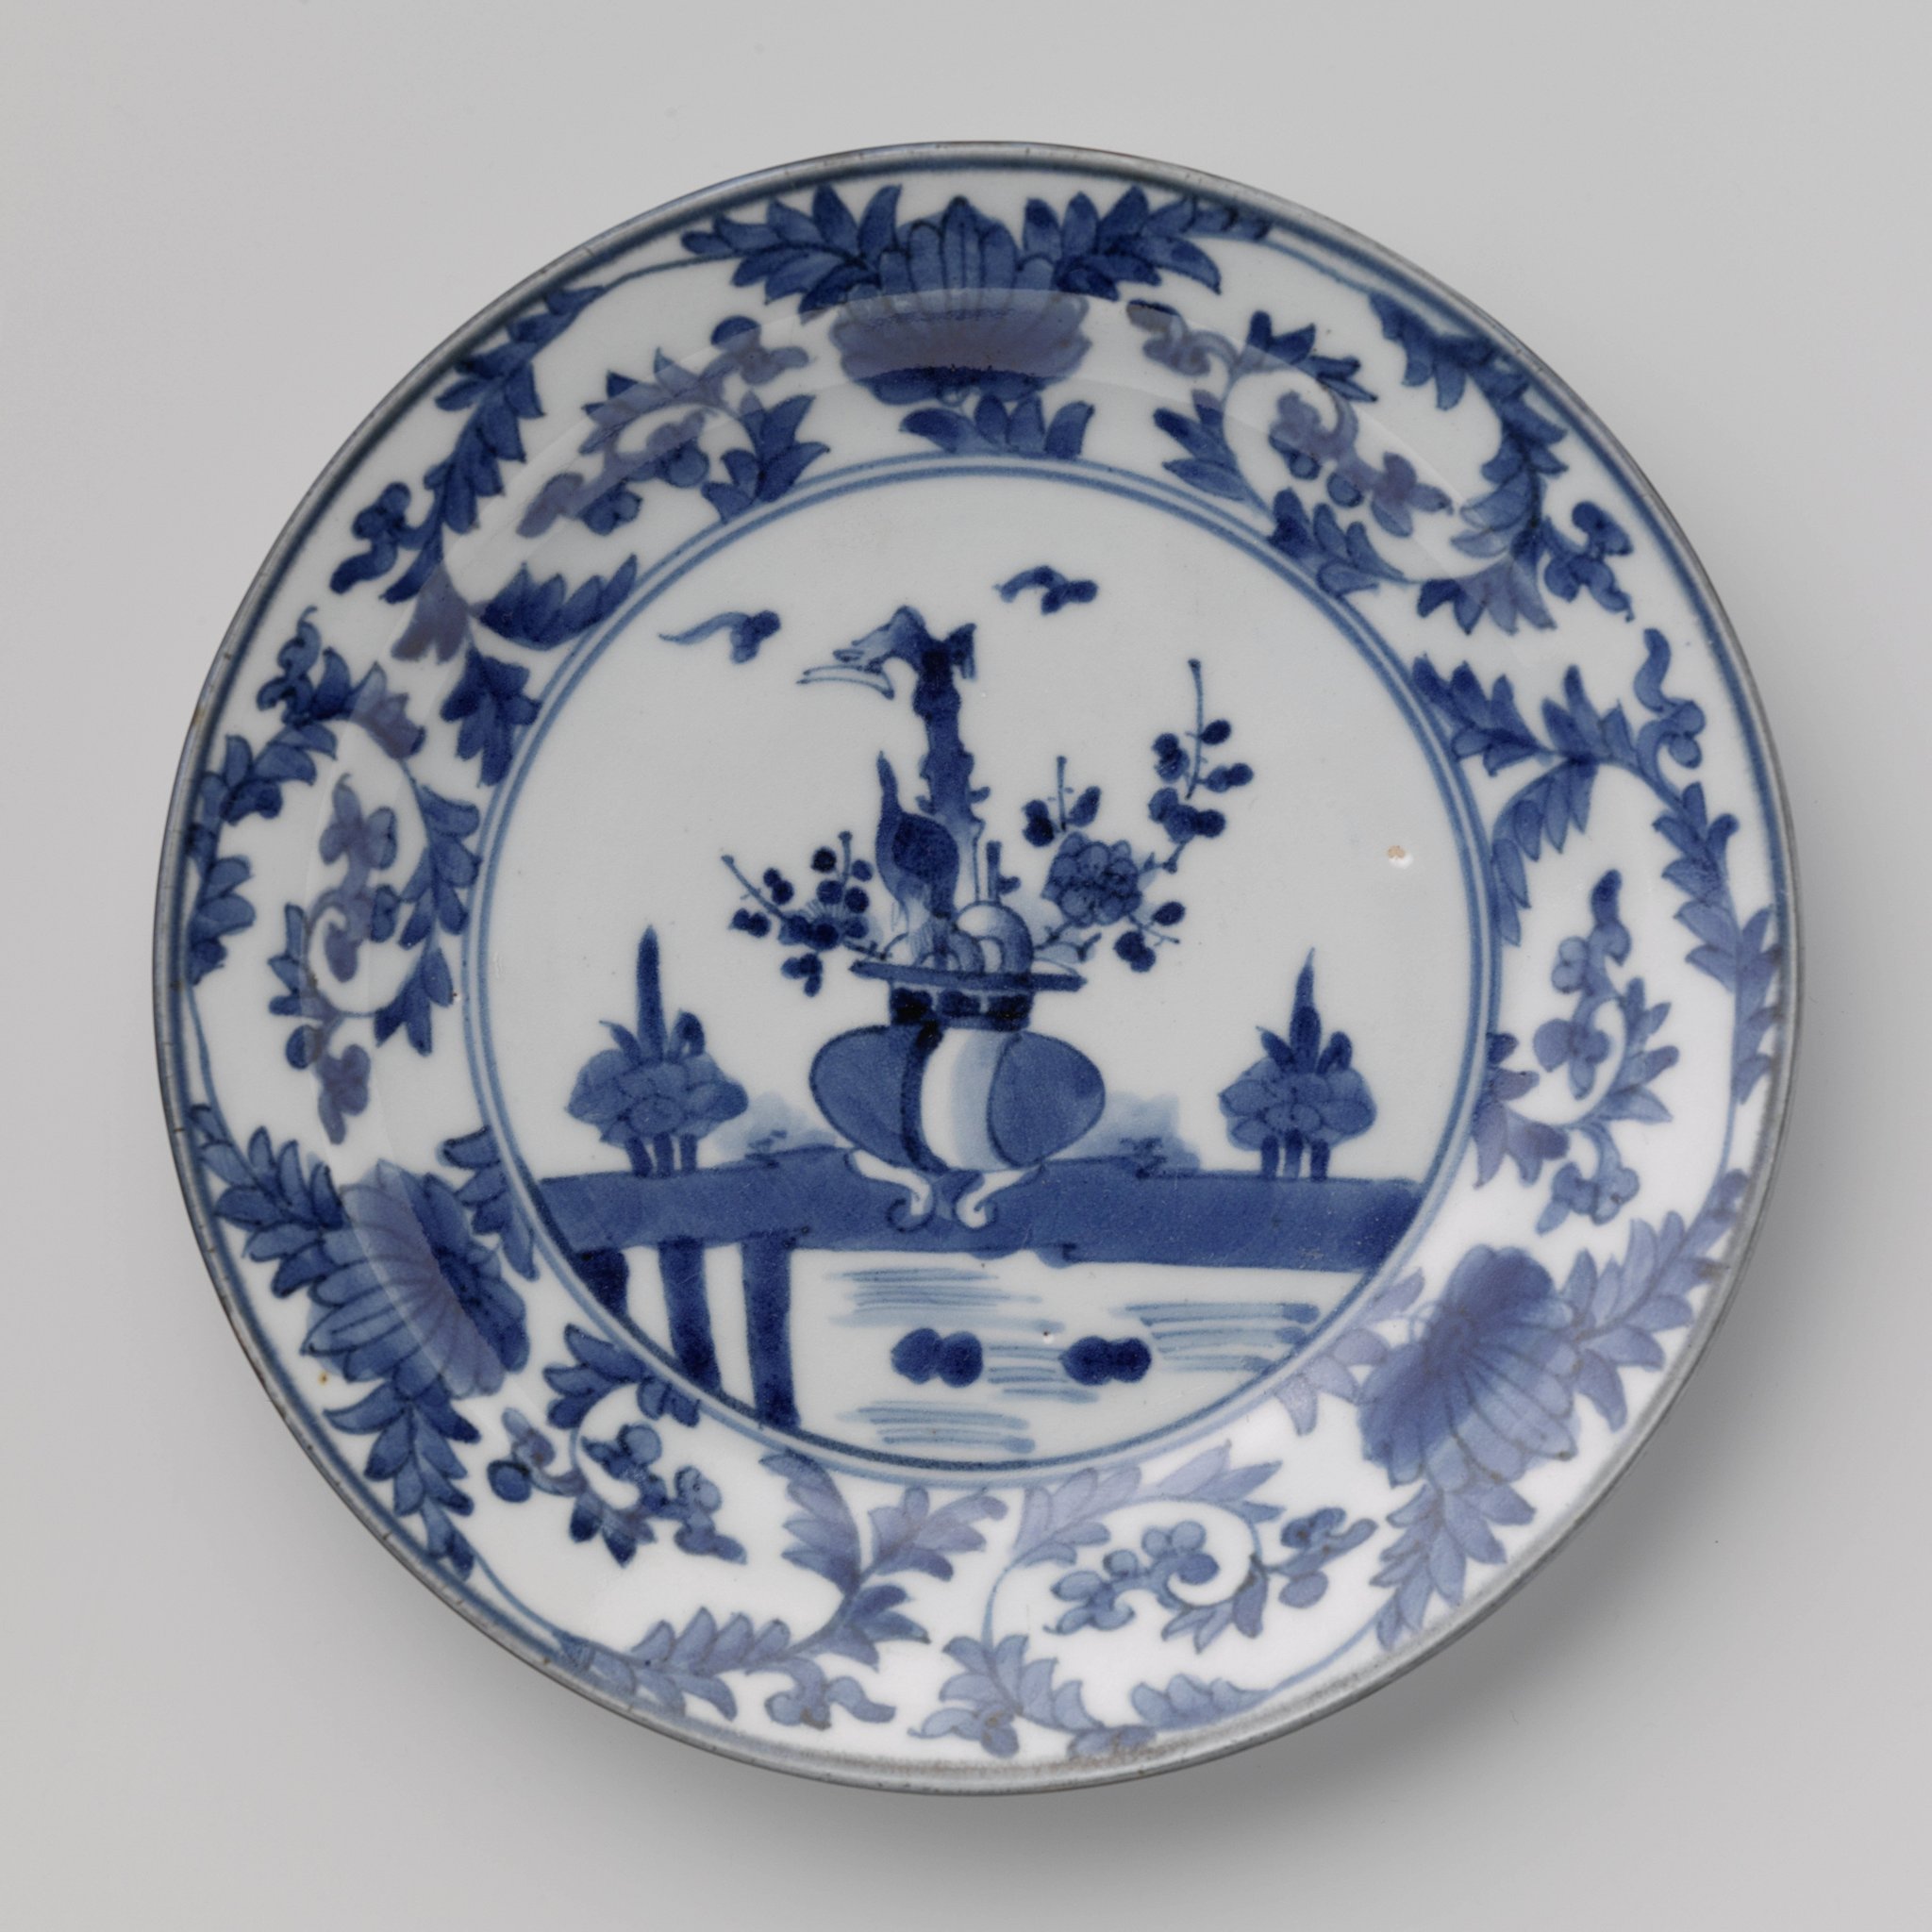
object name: plate dish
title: Plate with a flowerpot and floral scrolls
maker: Anonymous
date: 1660-1690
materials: cobalt, glaze, paint, porcelain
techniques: firing, turning, vitrification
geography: arita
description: When China was ravaged by war in the mid-17th century it became harder to obtain export porcelain. So the Dutch East India Company (VOC) decided to order the same style of porcelain in Japan. The VOC’s directors described their specifications in a letter from 1661: ‘the dishware should be made flat, and of the same kind of flower work as the old Chinese porcelain.’